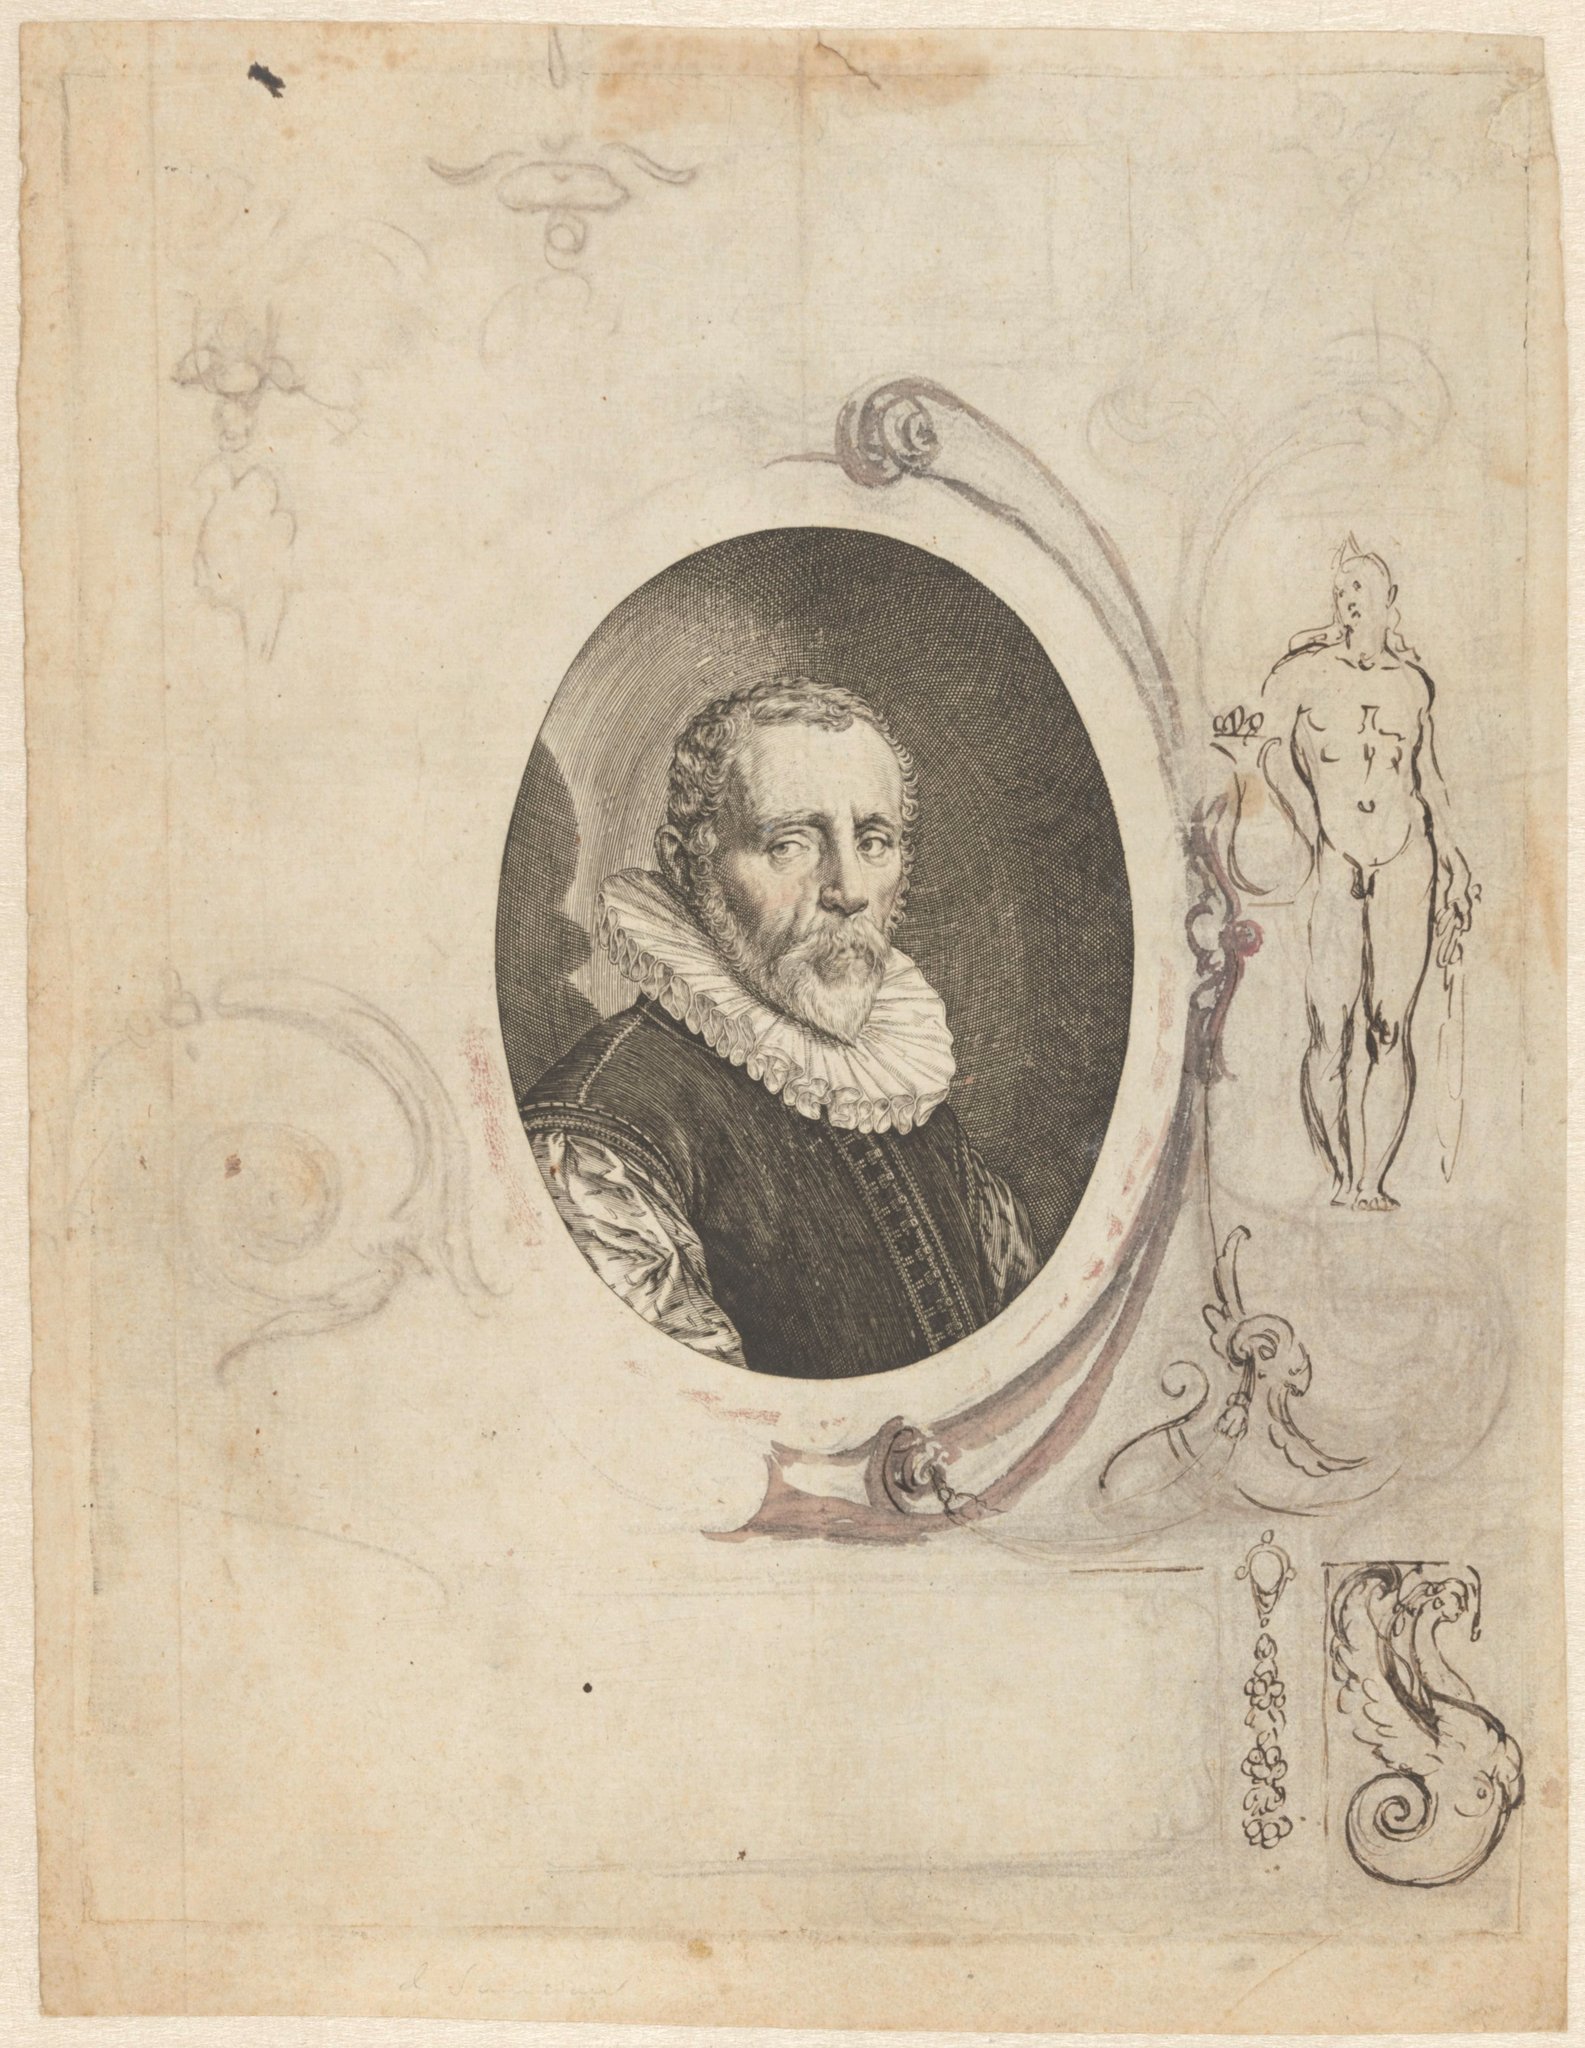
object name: drawing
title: Portrait of Pieter Hogerbeets, with a Design Sketch for the Frame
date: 1599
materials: chalk, paper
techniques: brush, engraving, pen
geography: haarlem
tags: petrus hogerbeets, historical persons, portrait of a writer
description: With the support of the F.G. Waller-Fonds, the museum acquires not only prints, but also related drawings. This is a drawn design for the surround of a portrait engraving. The draughtsman Karel van Mander was here trying out suitable ornamentation for the portrait of the learned physician Hoogerbeets. The engraver’s final design turned out to be very different.